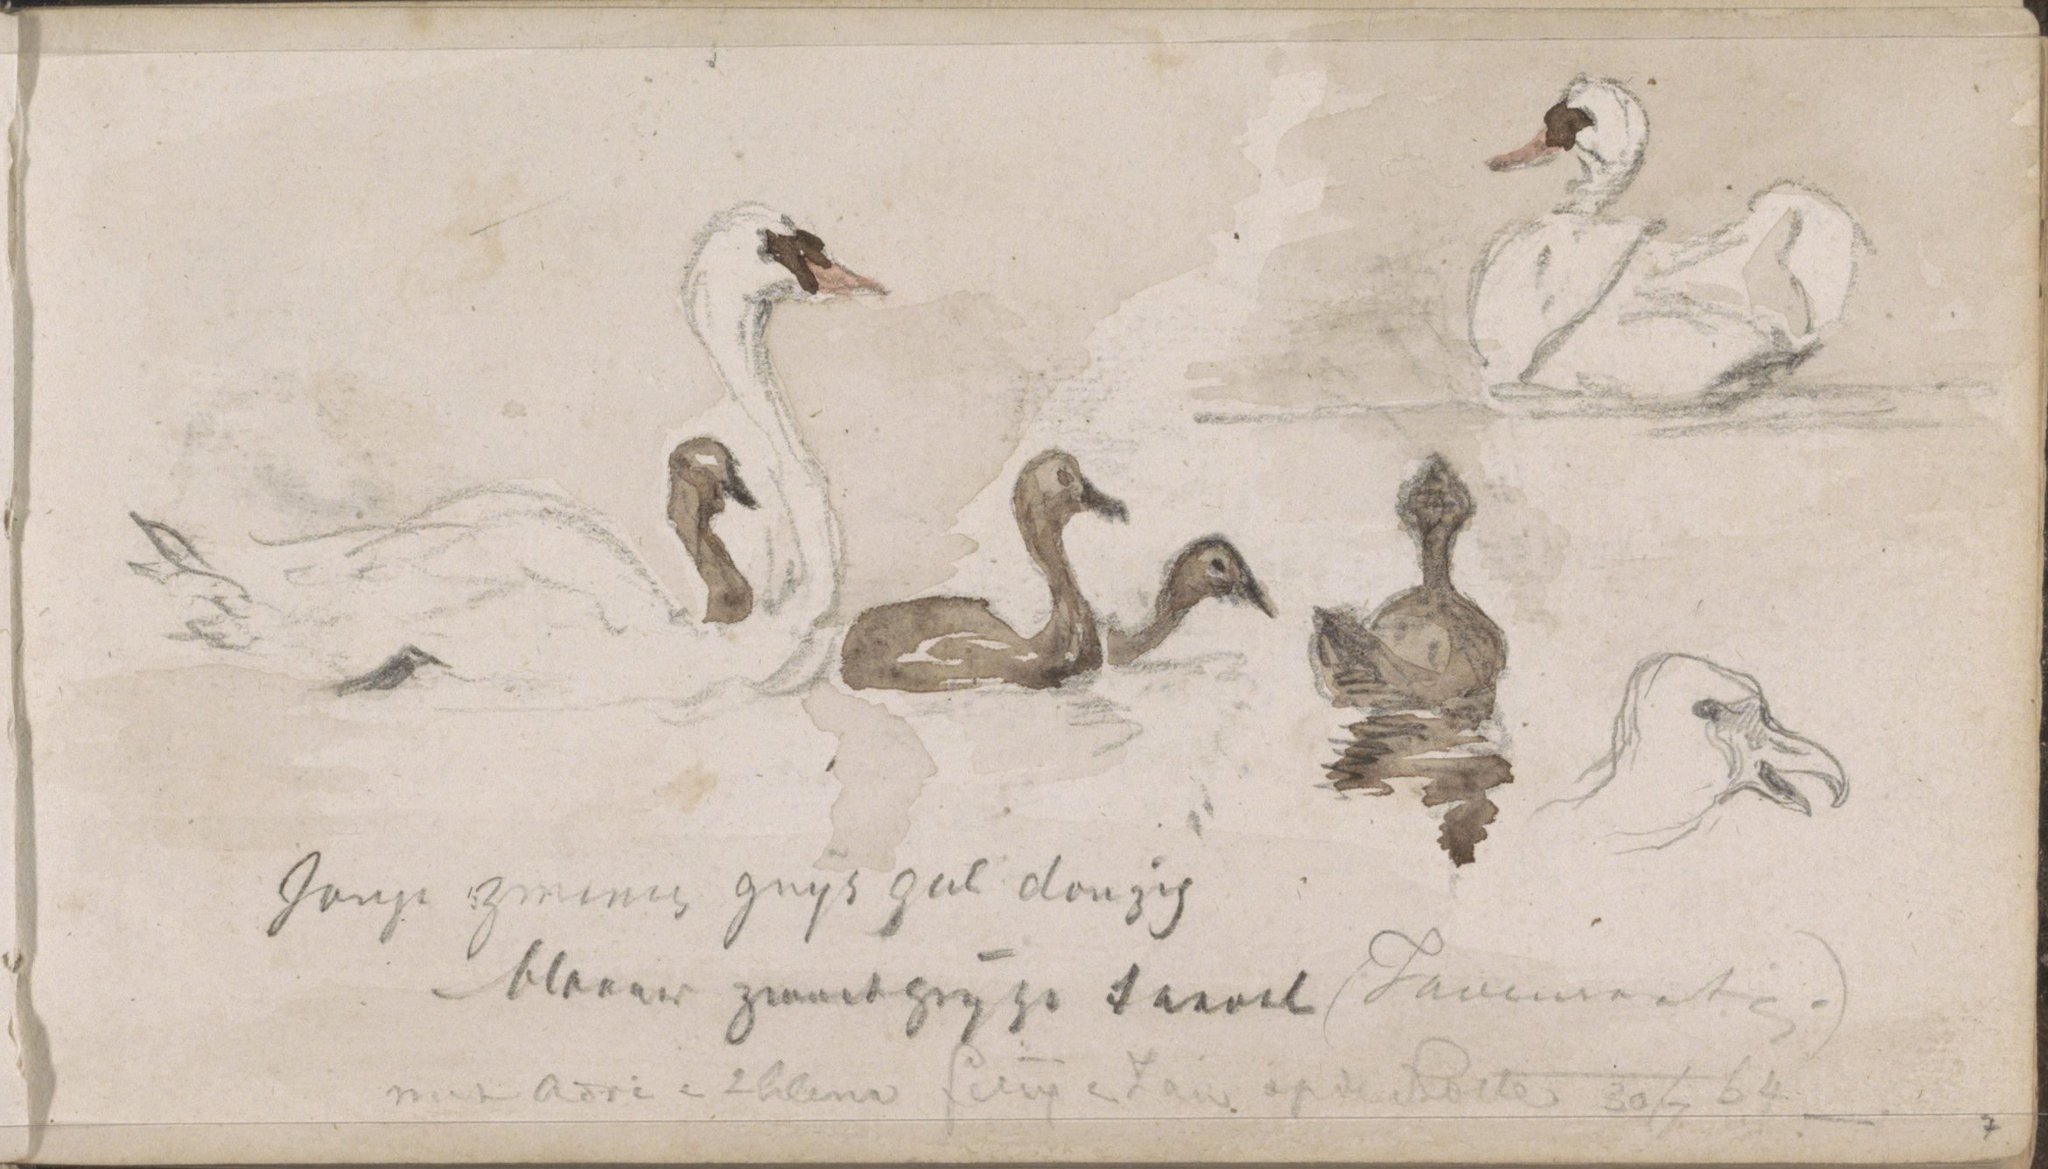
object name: sketchbook leaf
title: Jonge en oudere zwanen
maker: johannes tavenraat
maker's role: draughtsman, painter, print maker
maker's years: 1809-1881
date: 1807-1864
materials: ink, paper, pencil, watercolor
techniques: brush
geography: rotte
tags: water-birds: swan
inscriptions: signature: ‘Tavenraat’, date and inscription: ‘jonge zwanen grijs geel donzig/ blauw zwart grijs snavel [...]/ met Adri & Helena [...] op de Rotte 30/7 64’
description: Blad 7 recto uit een schetsboek met 98 bladen.